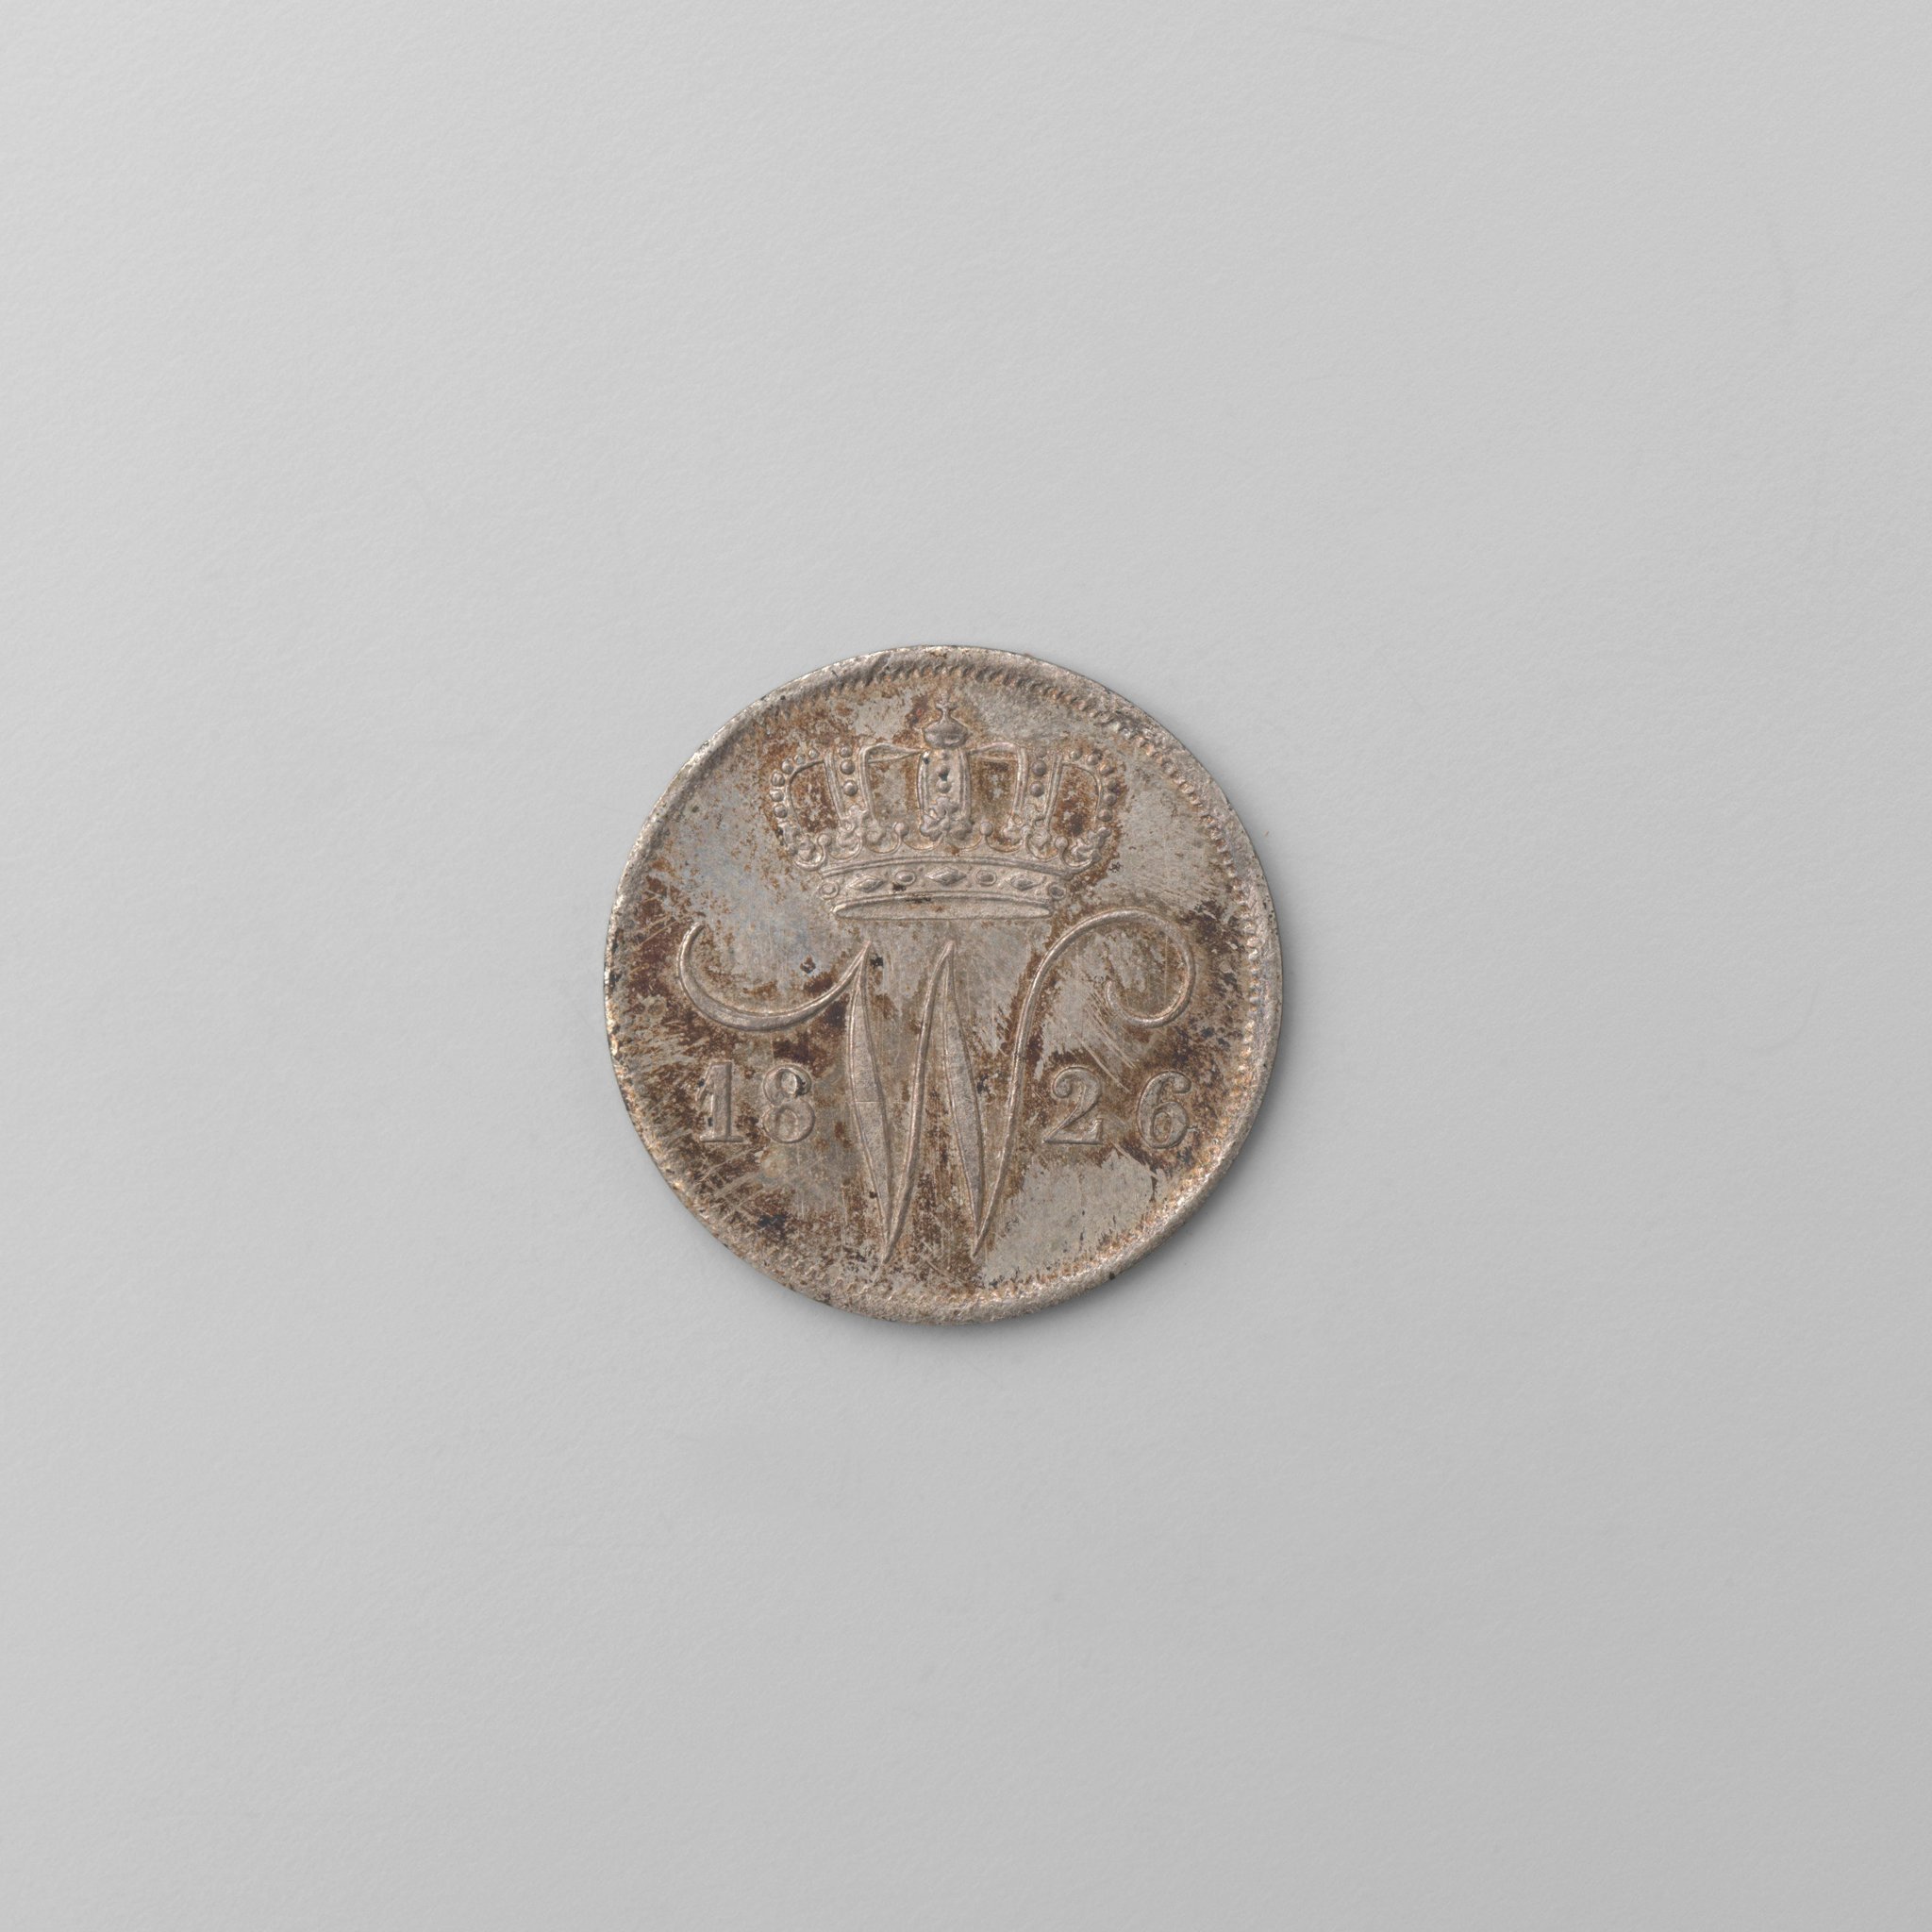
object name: tien cent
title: Nederland, 10 cent, 1826 Utrecht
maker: william i of the netherlands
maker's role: koning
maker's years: 1772-1843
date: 1826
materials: silver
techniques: striking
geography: utrecht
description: Zilveren munt. Voorzijde: tussen jaartal gekroonde cursieve letter W. Keerzijde: tussen waarde-aanduiding 10 C. gekroond rijkswapenschild. Gladde rand.